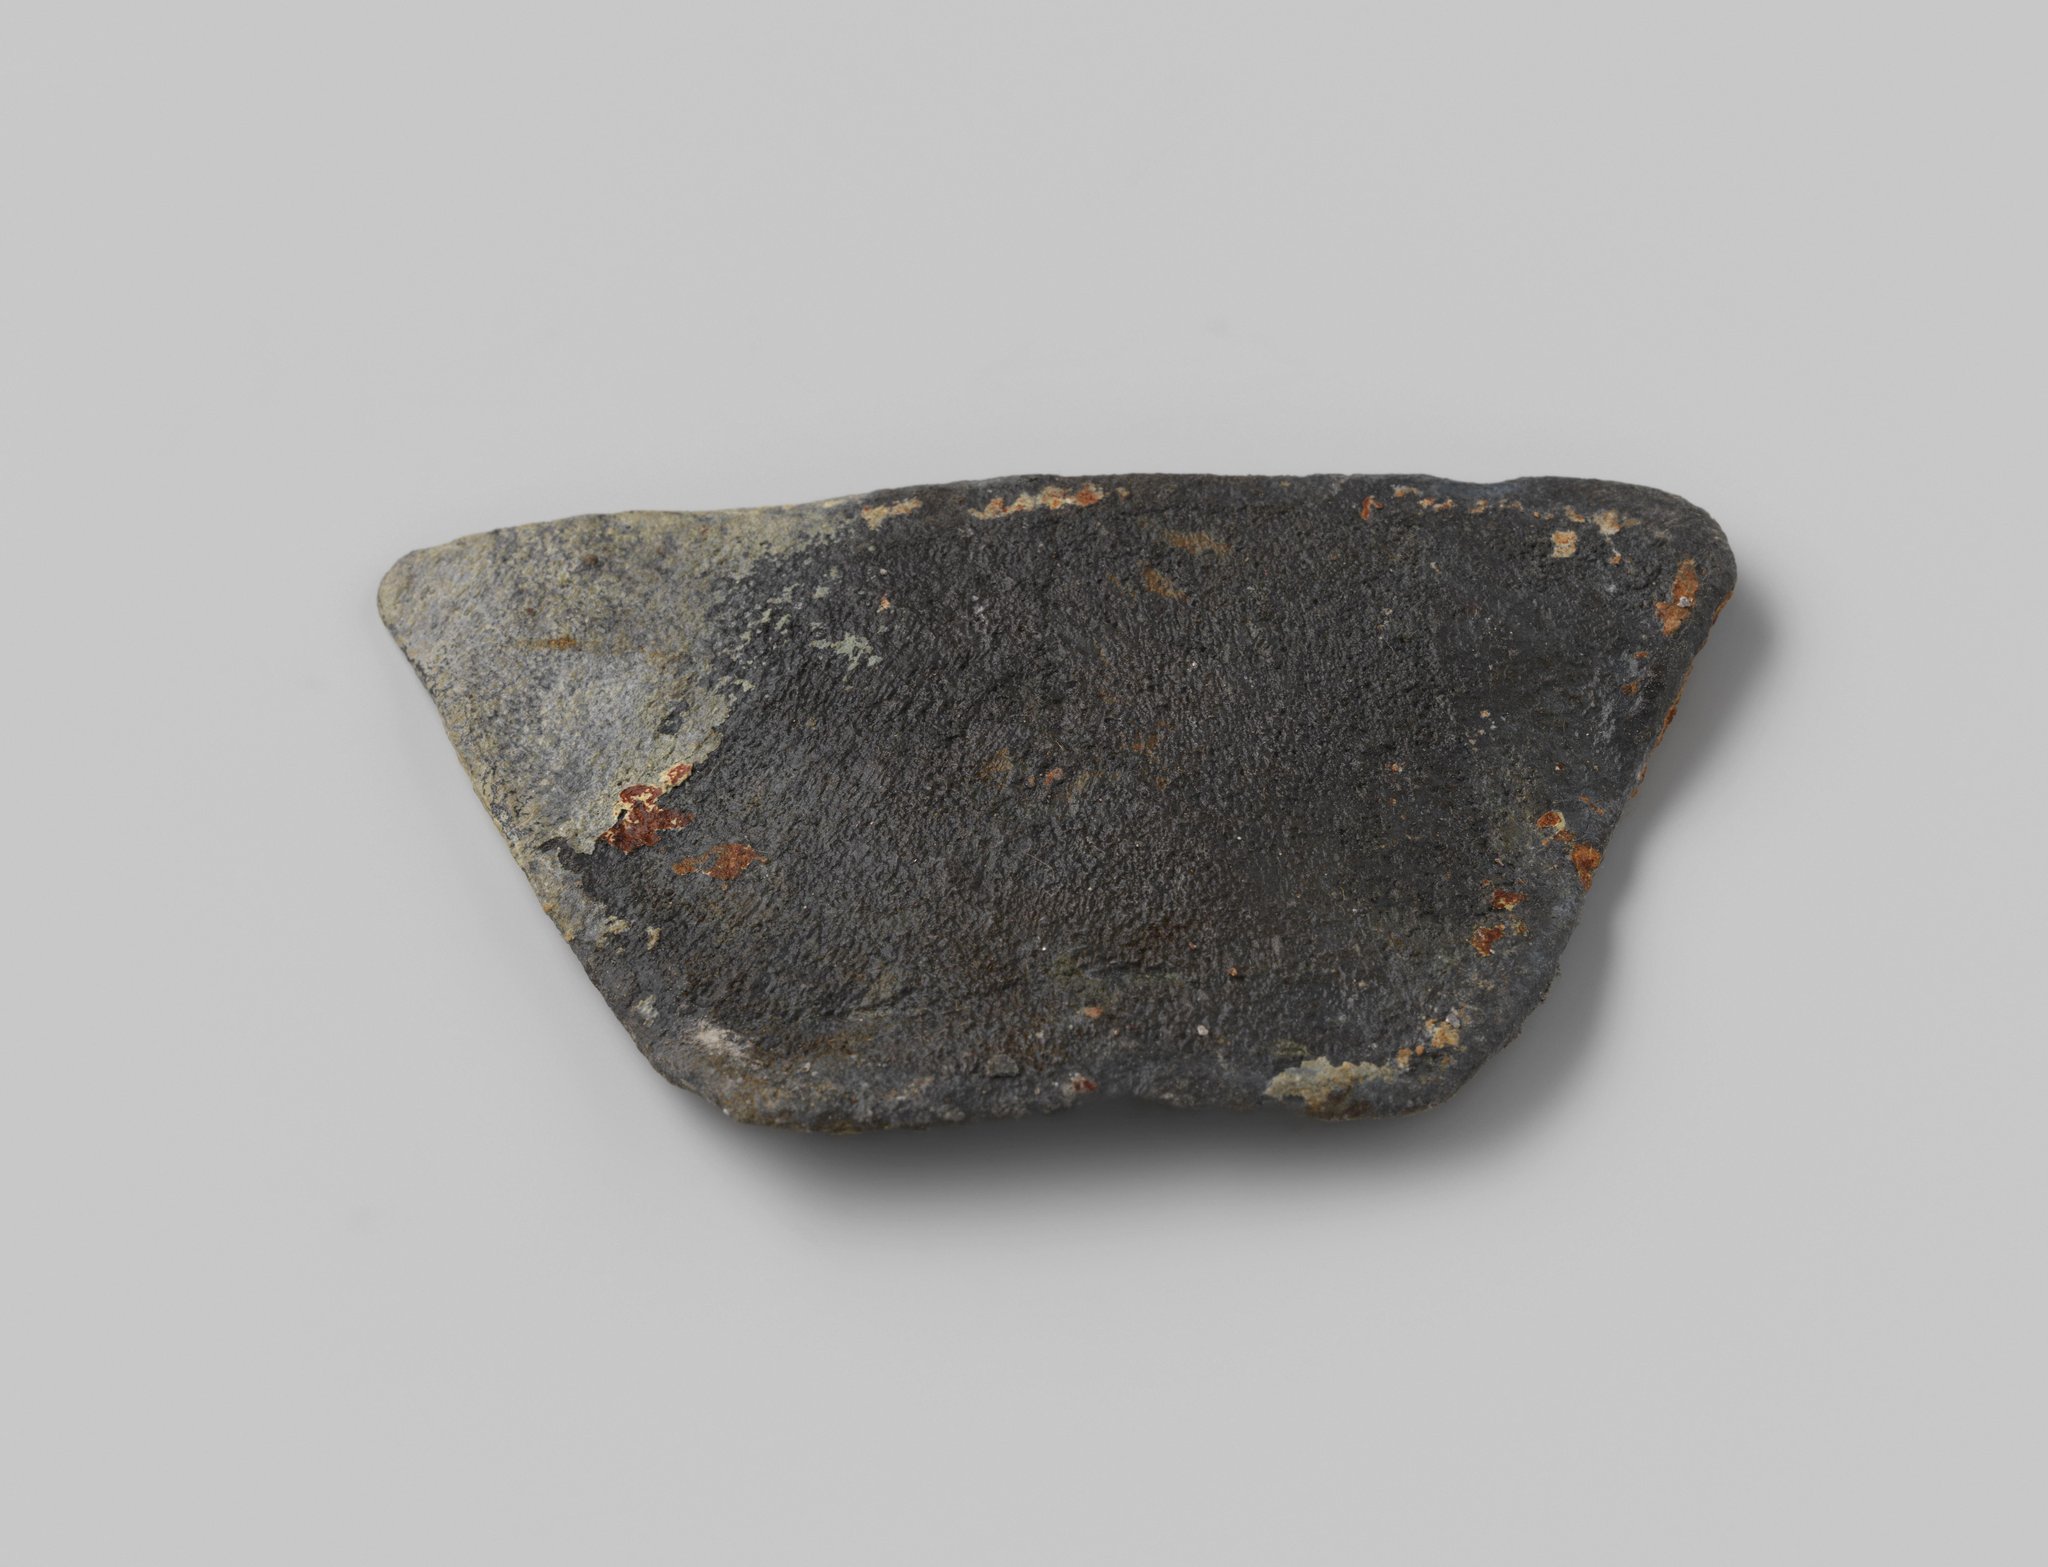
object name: fragment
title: Fragment van lood uit het wrak van de Oost-Indiëvaarder Hollandia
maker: Anonymous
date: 1700-1743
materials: lead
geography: netherlands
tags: verenigde oostindische compagnie, hollandia (schip), annet